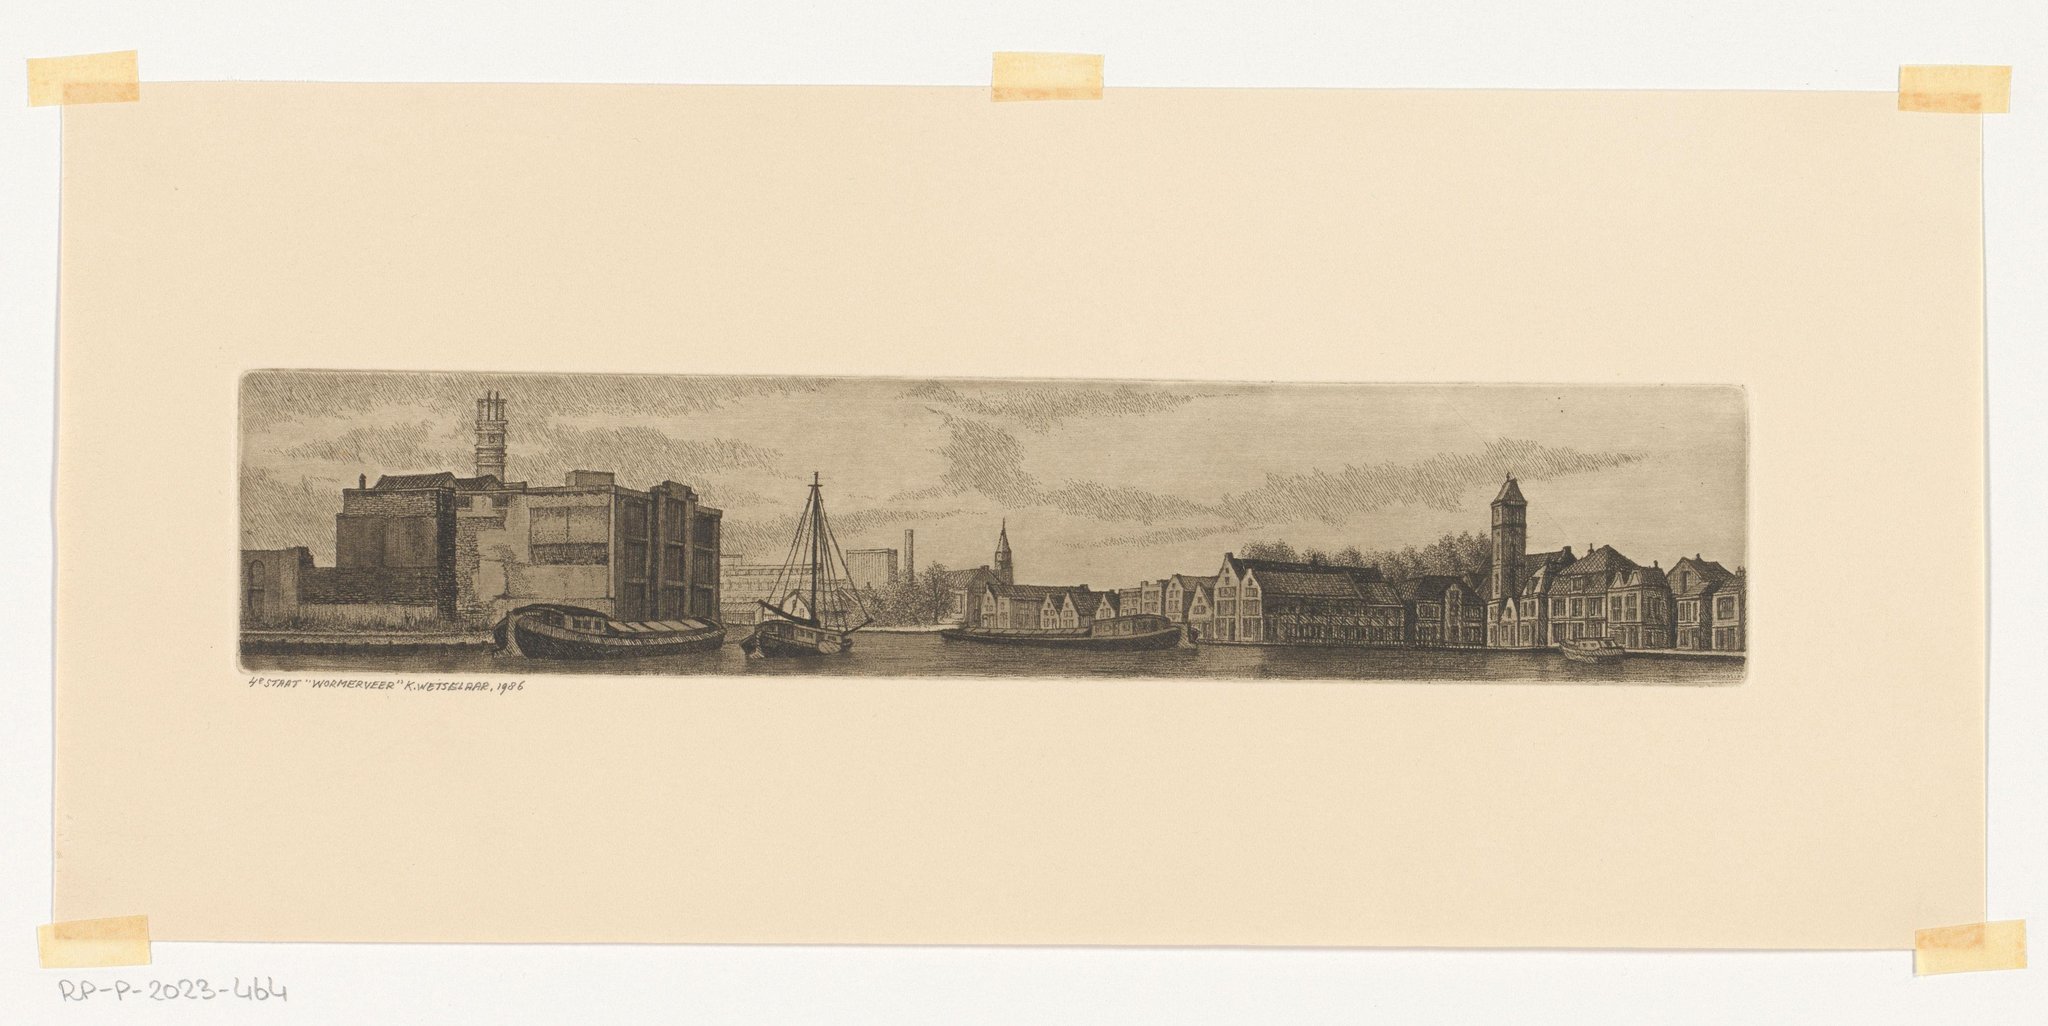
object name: print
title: Wormerveer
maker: karel wetselaar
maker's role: print maker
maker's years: 1935-2017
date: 1986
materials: paper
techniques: aquatint, etching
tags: canals, waters (in village), village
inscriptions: signature and date: ‘K. Wetselaar 1986’, inscription: ‘4e staat’